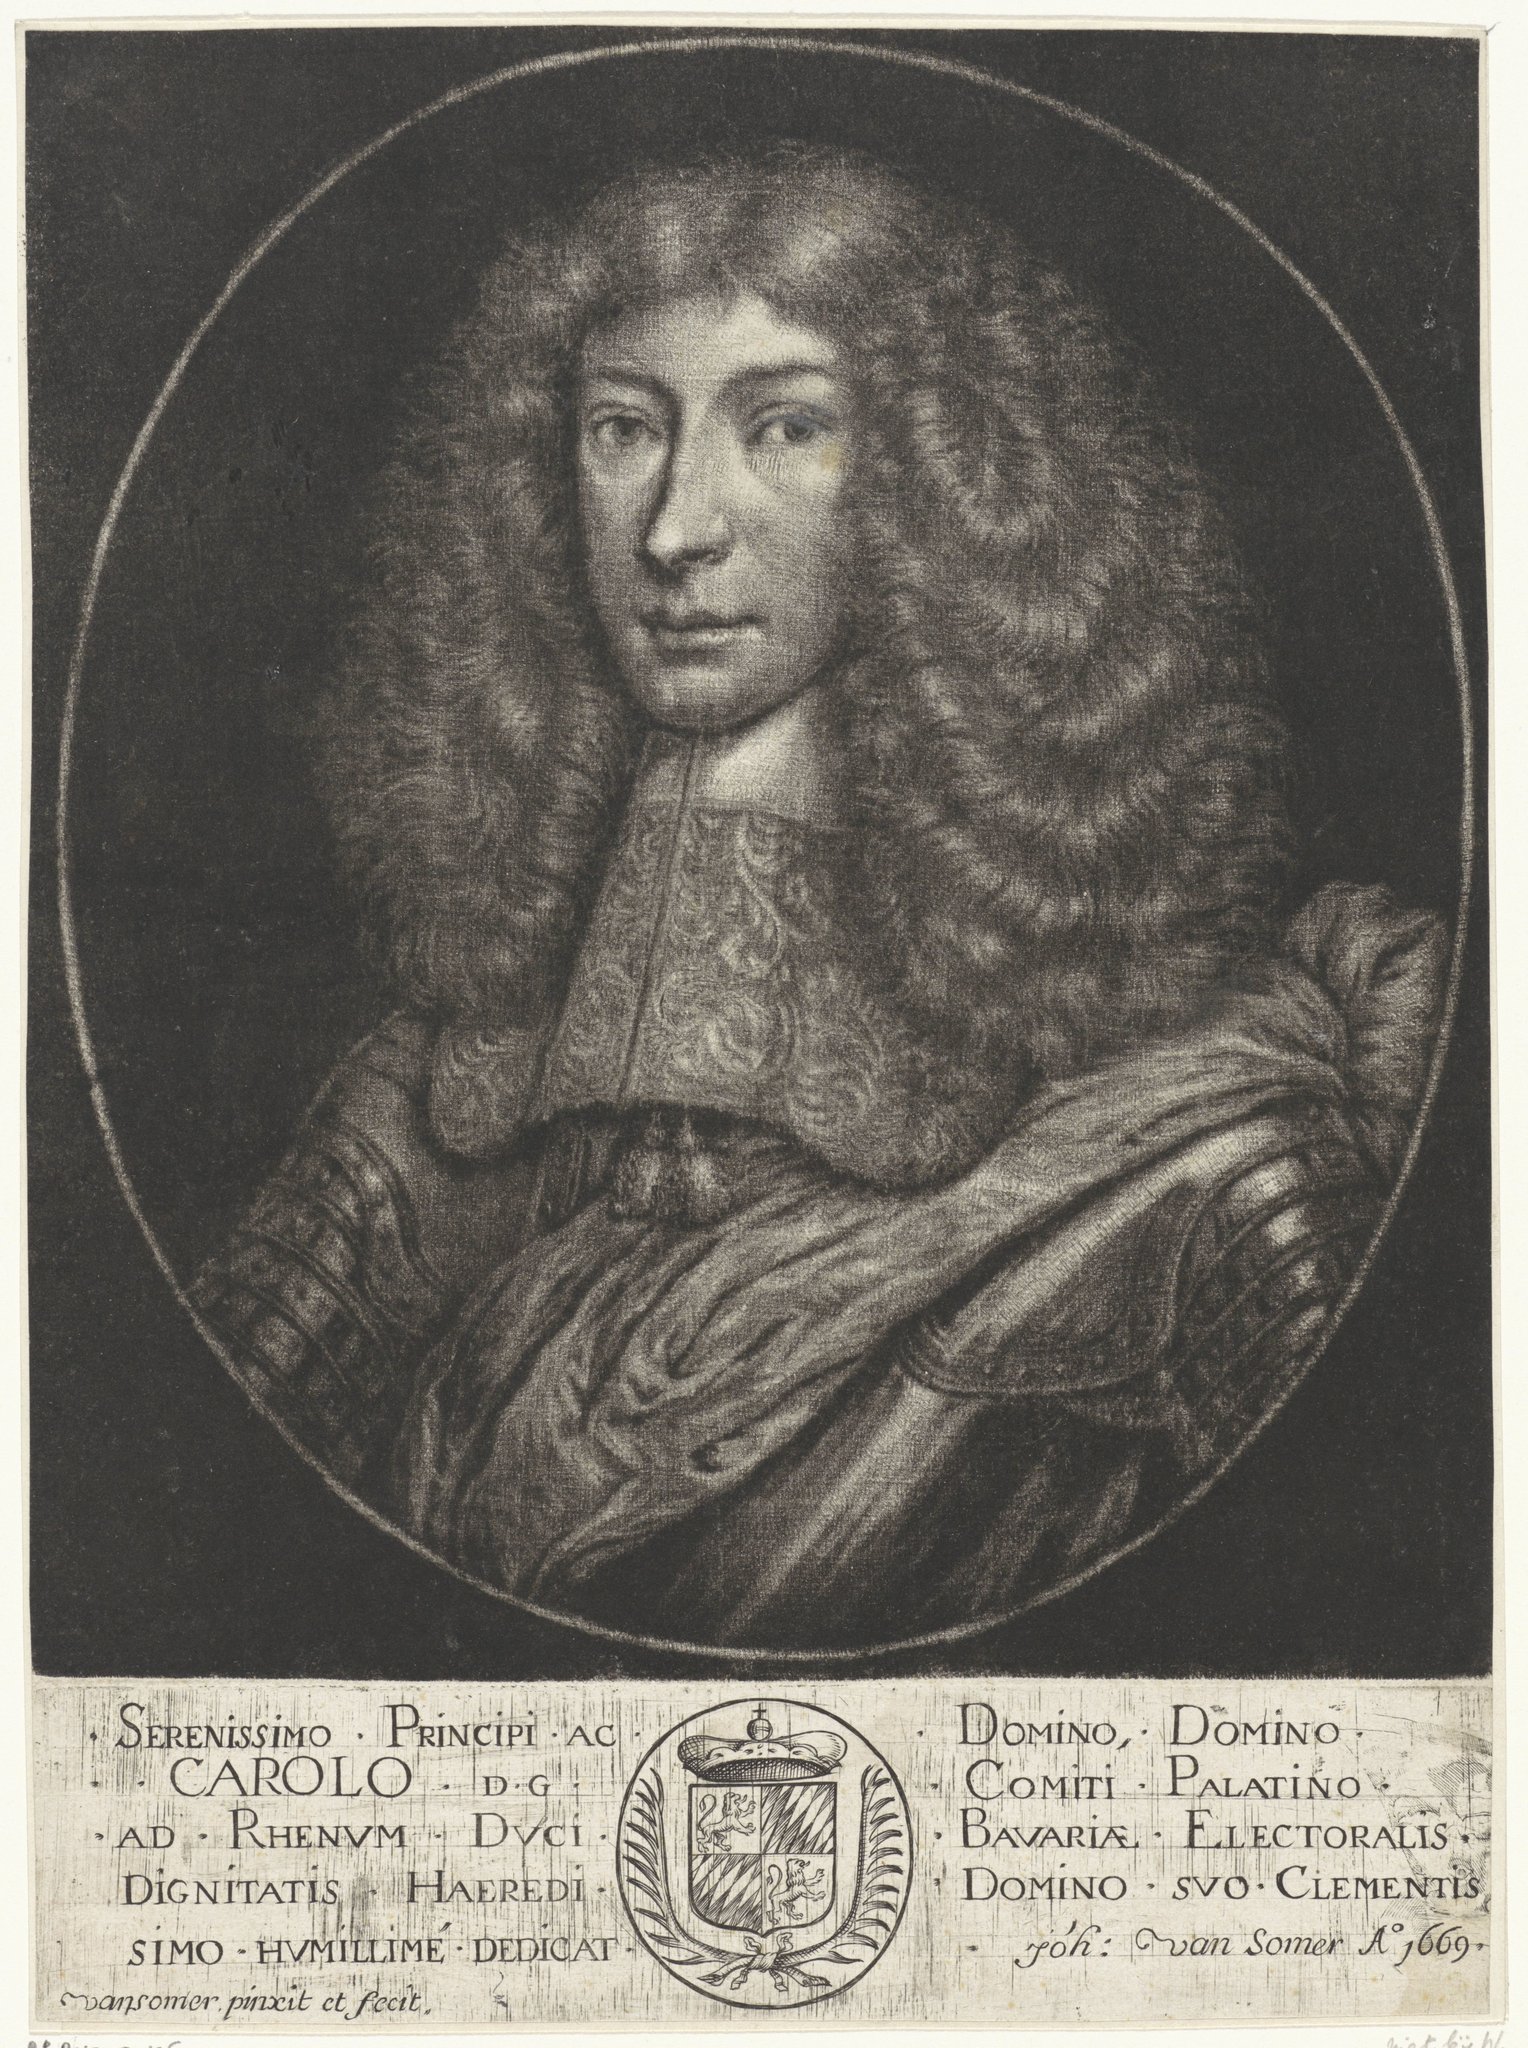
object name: print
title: Portret van Karel Lodewijk van de Palts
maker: jan van somer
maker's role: draughtsman, print maker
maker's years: 1645-1699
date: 1669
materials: paper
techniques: engraving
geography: heidelberg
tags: armorial bearing, heraldry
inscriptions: collector's mark: Lugt 2228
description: Karel Lodewijk, keurvorst van de Pals. Onderaan in de marge zijn familiewapen, naam en titels.